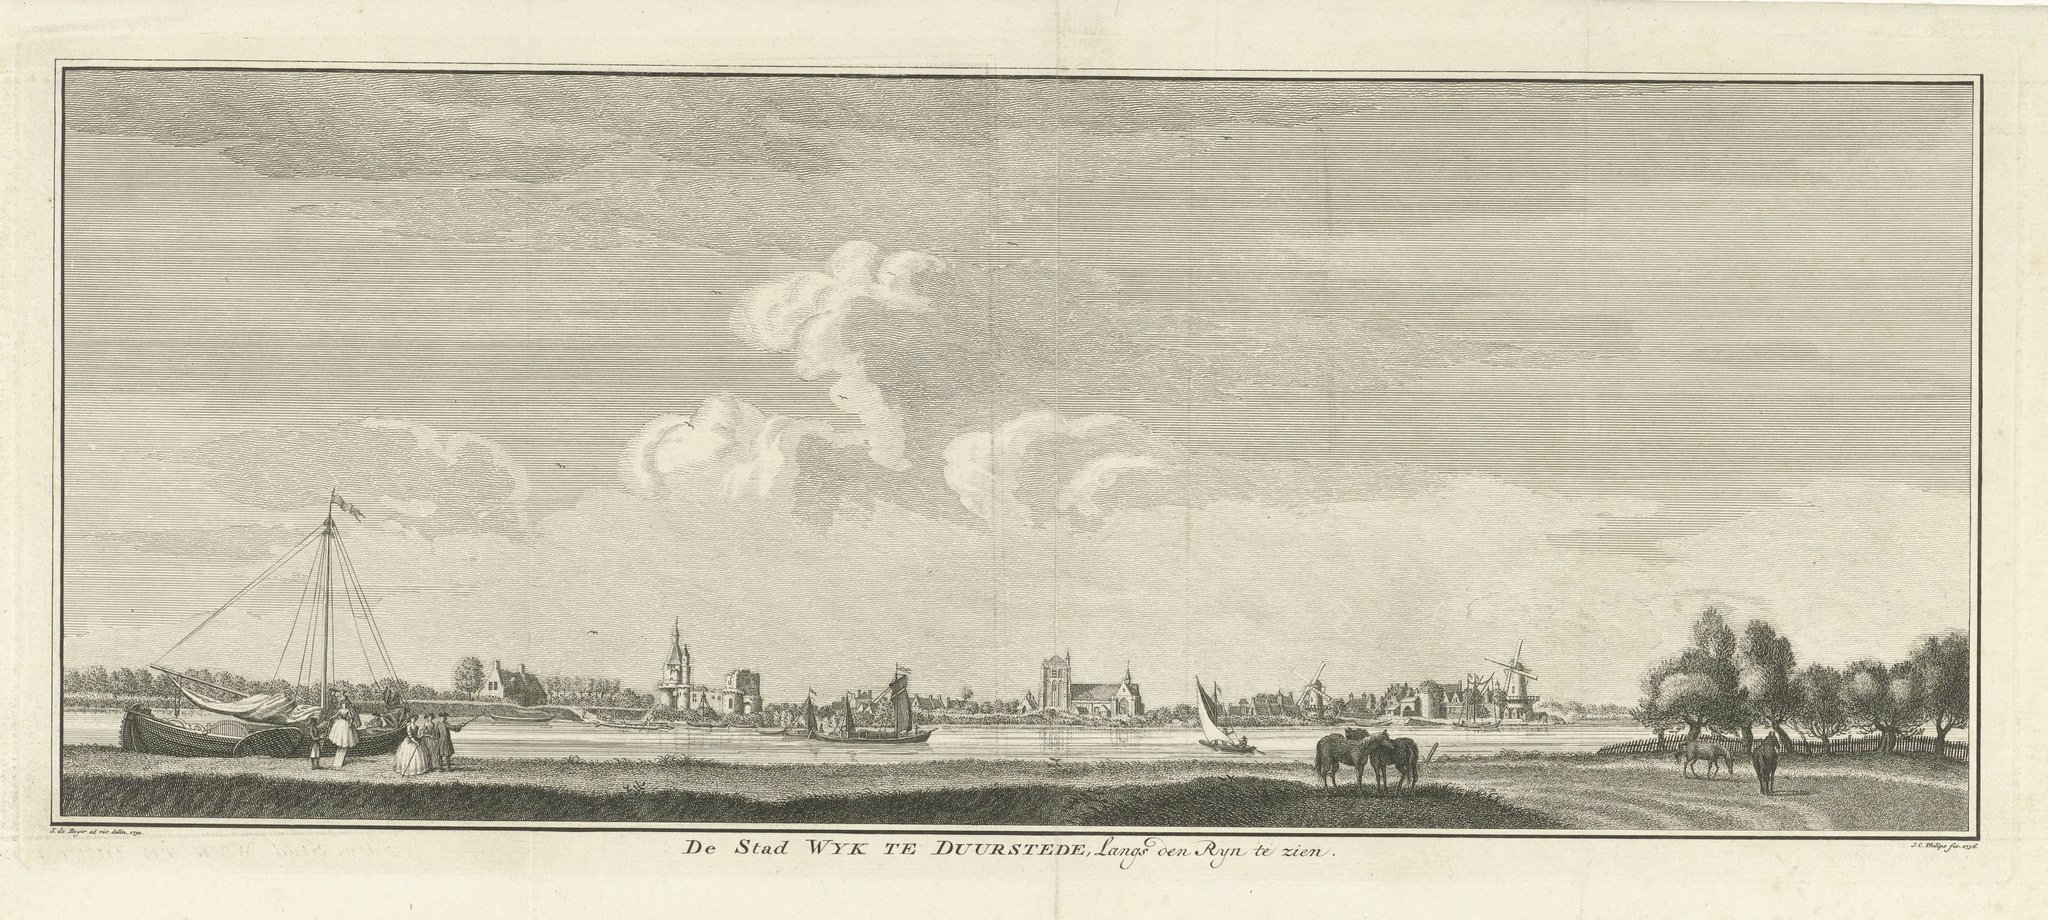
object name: print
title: De Stad Wyk te Duurstede, Langs den Rijn te zien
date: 1756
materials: paper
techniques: etching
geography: amsterdam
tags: city-view in general; 'veduta', wijk bij duurstede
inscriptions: collector's mark: Lugt 2228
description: Gezicht op Wijk bij Duurstede, gezien vanaf de oostoever van de Rijn, met onder andere kasteel Duurstede en de Grote Kerk.